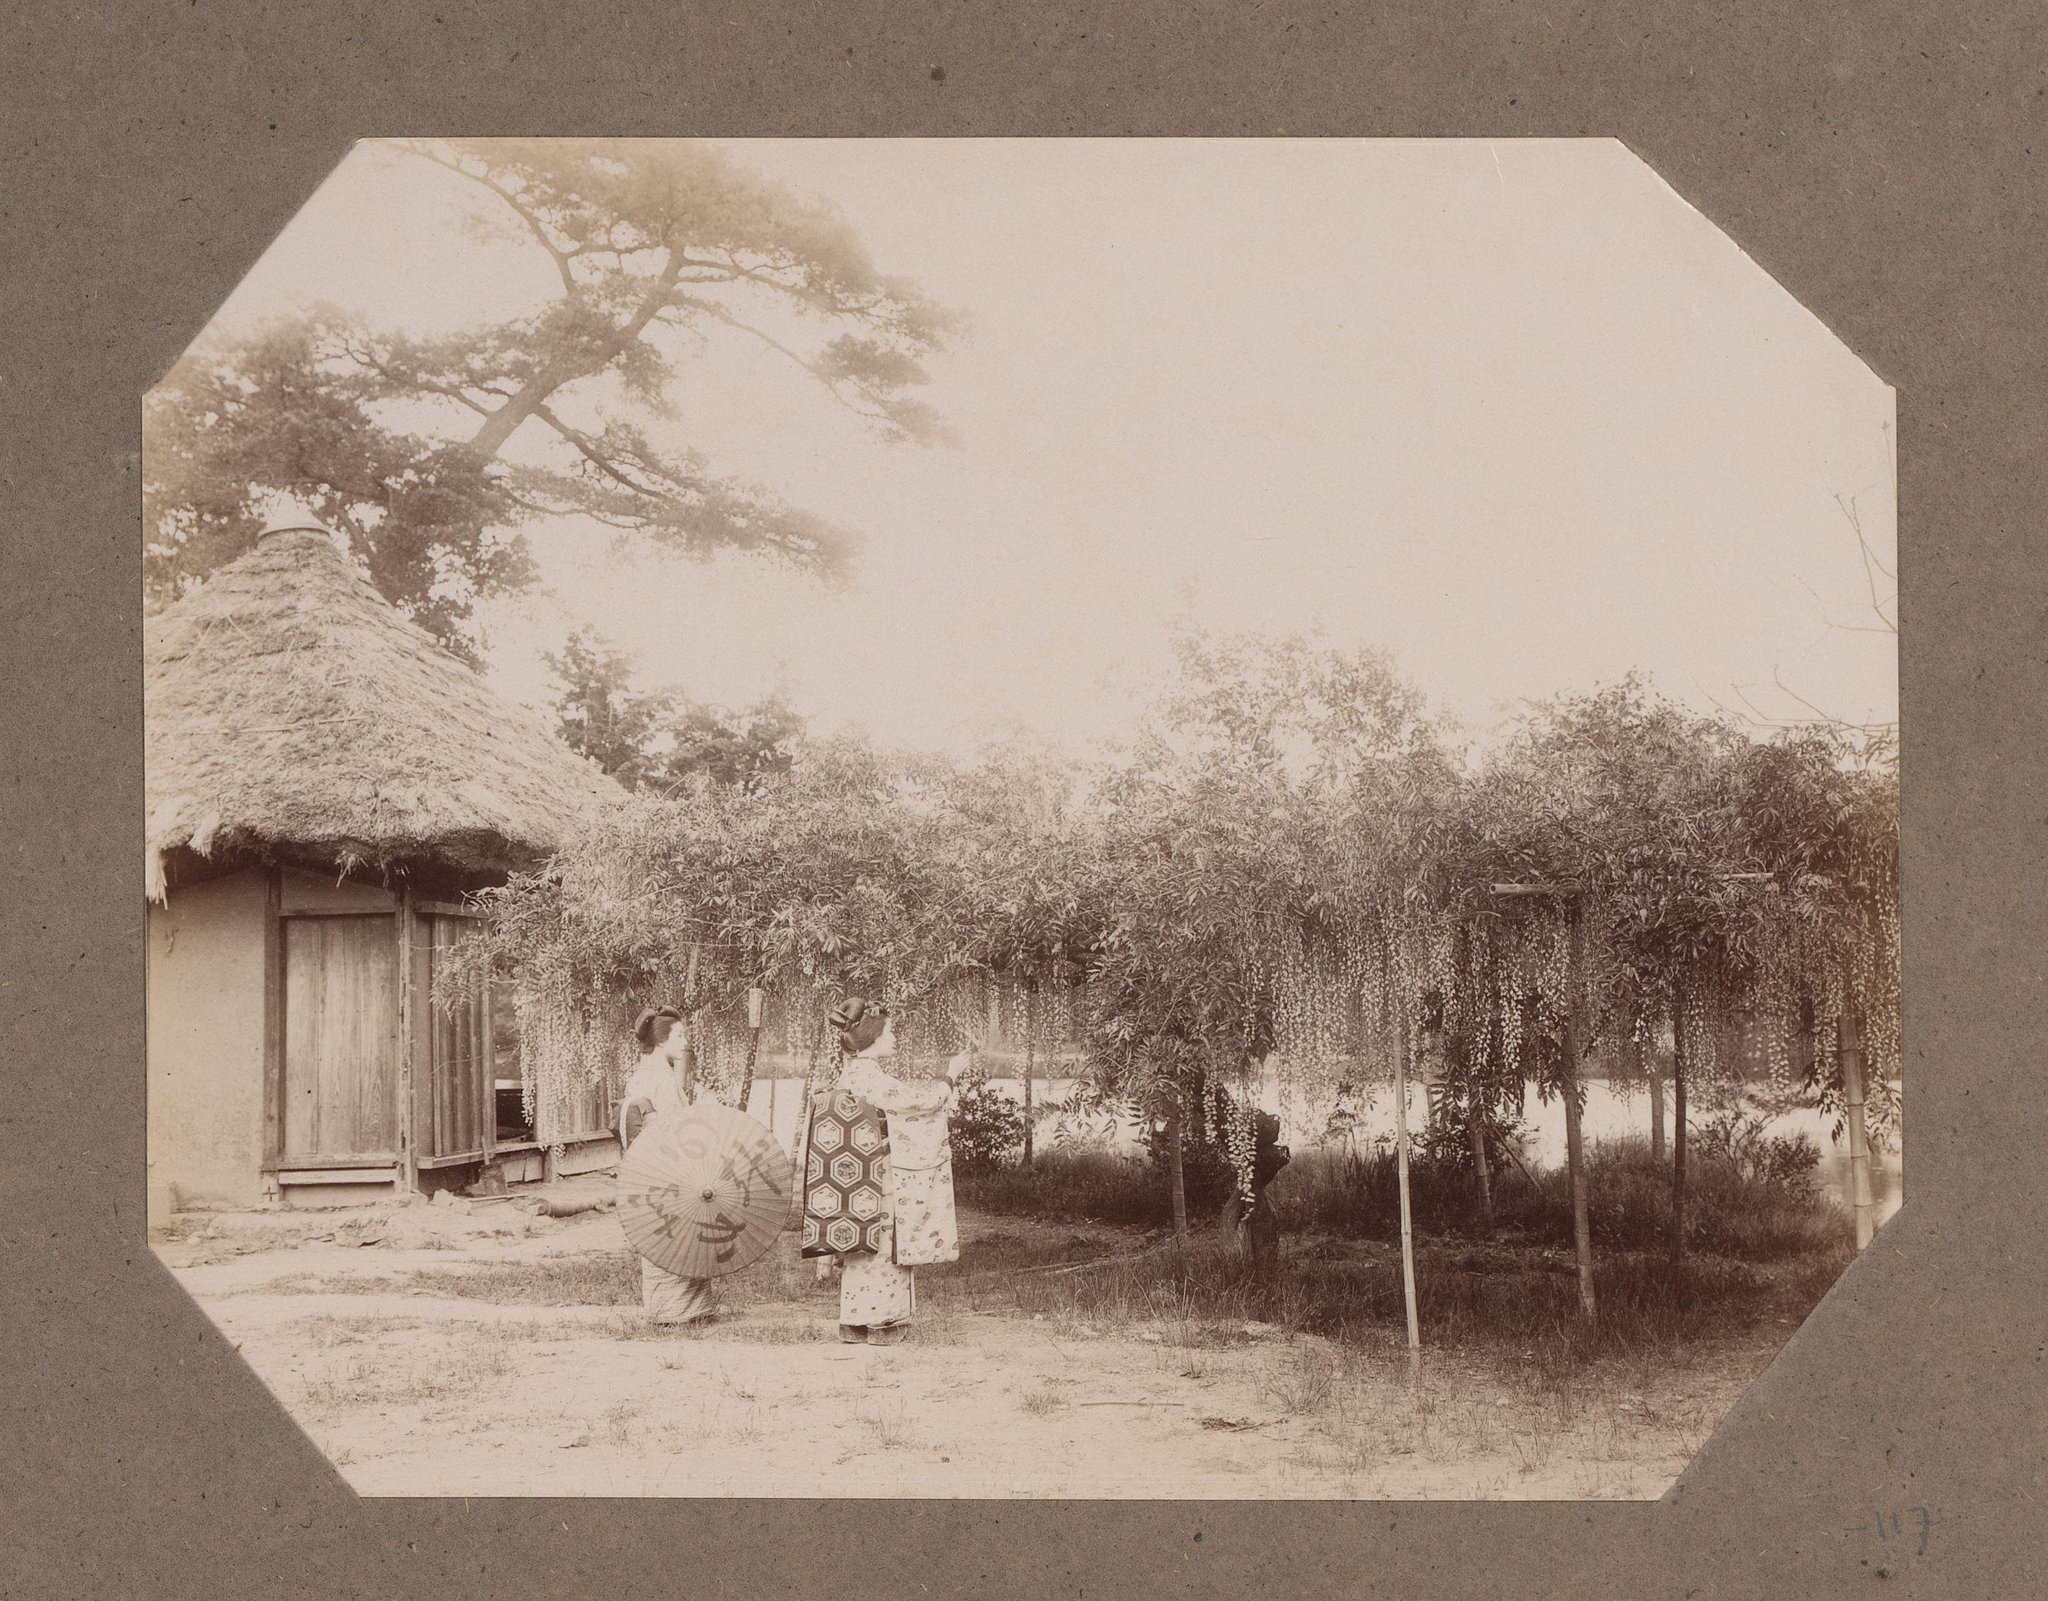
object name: photograph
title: Twee vrouwen bij een bloeiende blauweregen, Japan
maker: Anonymous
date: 1890-1903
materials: paper, photographic support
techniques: albumen print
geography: japan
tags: plants and herbs: wisteria, garden, adult woman (+ two persons), japan